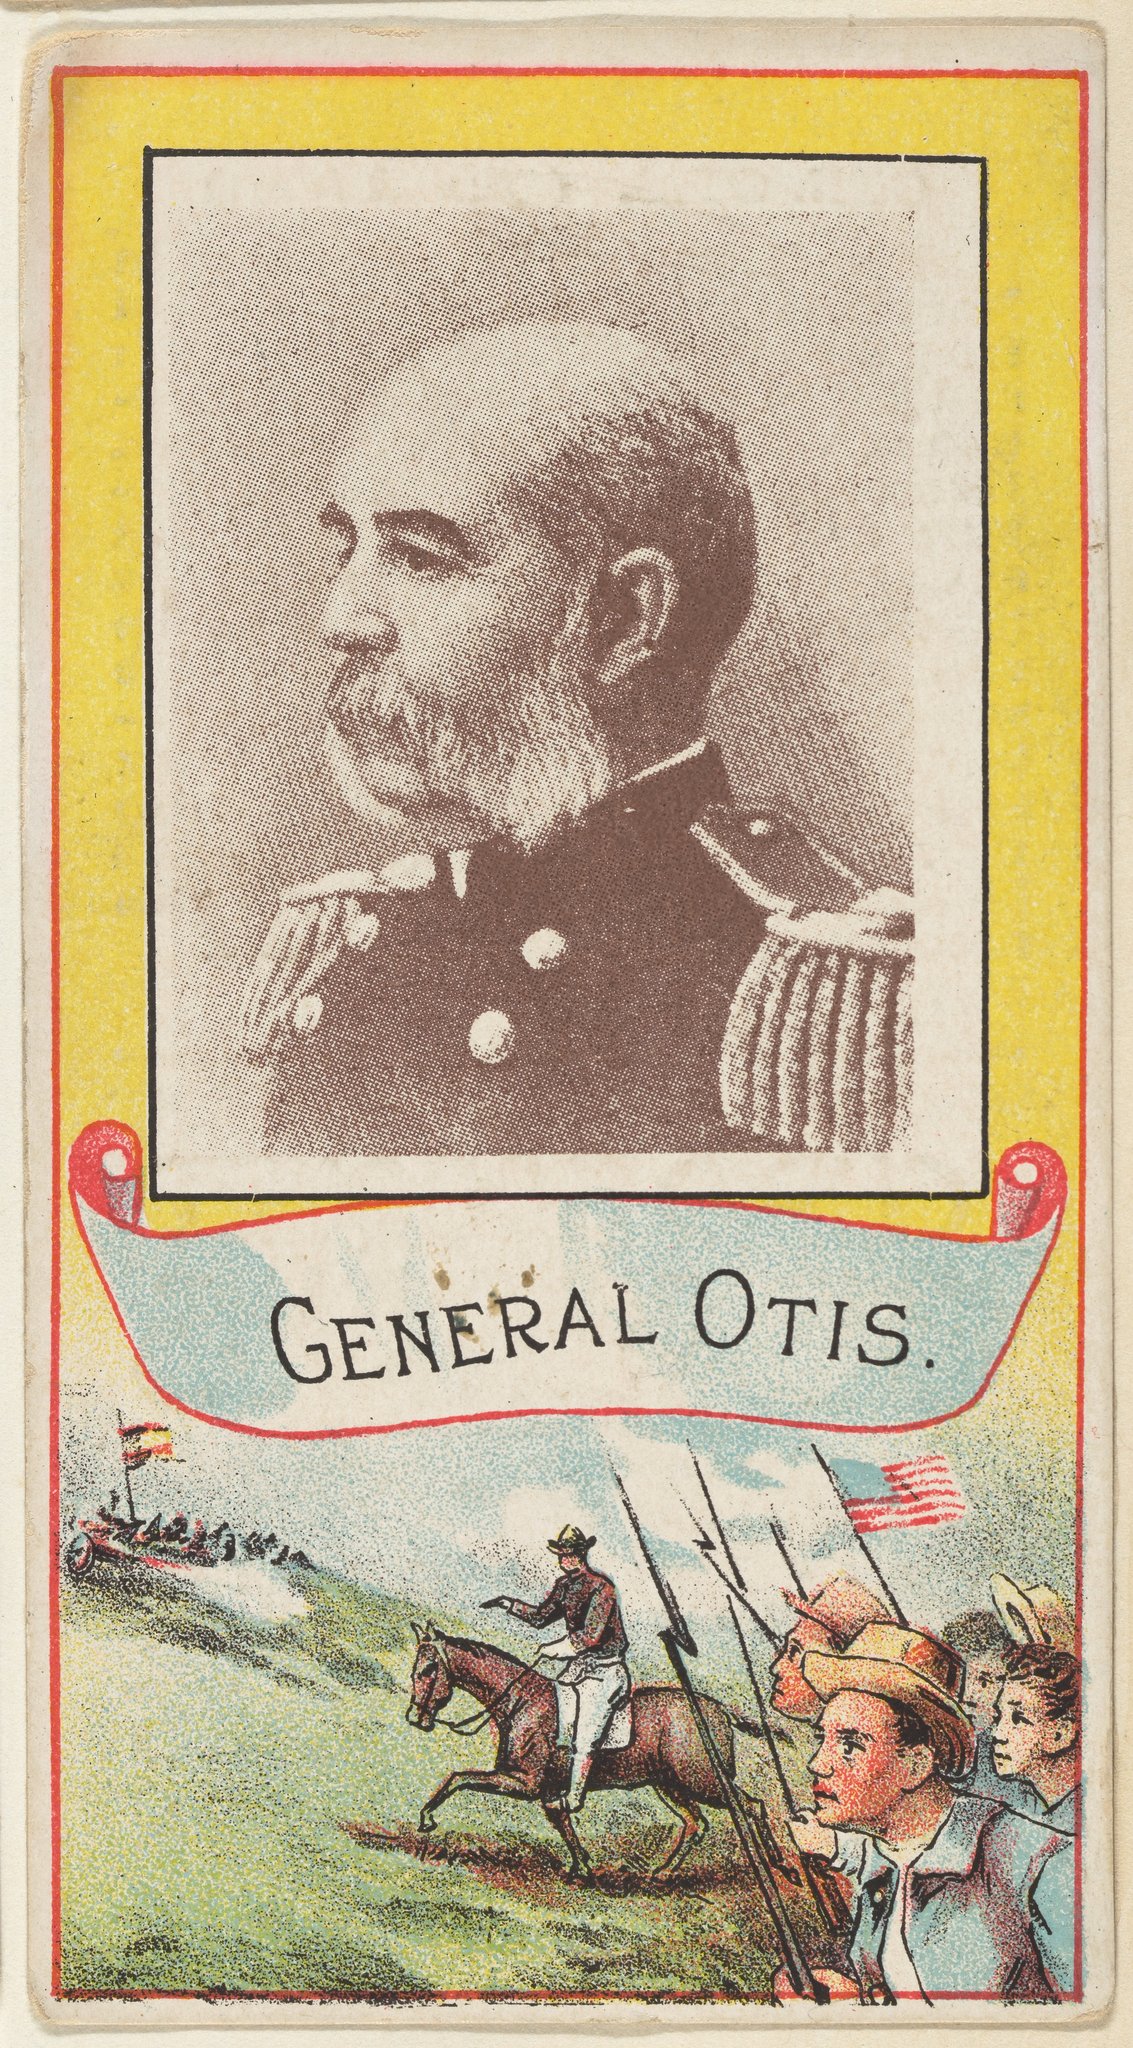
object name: print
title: General Otis, from the "Generals" series (T64), issued by D.H. McAlpin & Co. Tobacco Company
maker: d.h. mcalpin & co. tobacco company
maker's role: publisher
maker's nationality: american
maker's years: 1857-1901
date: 1901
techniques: color lithograph